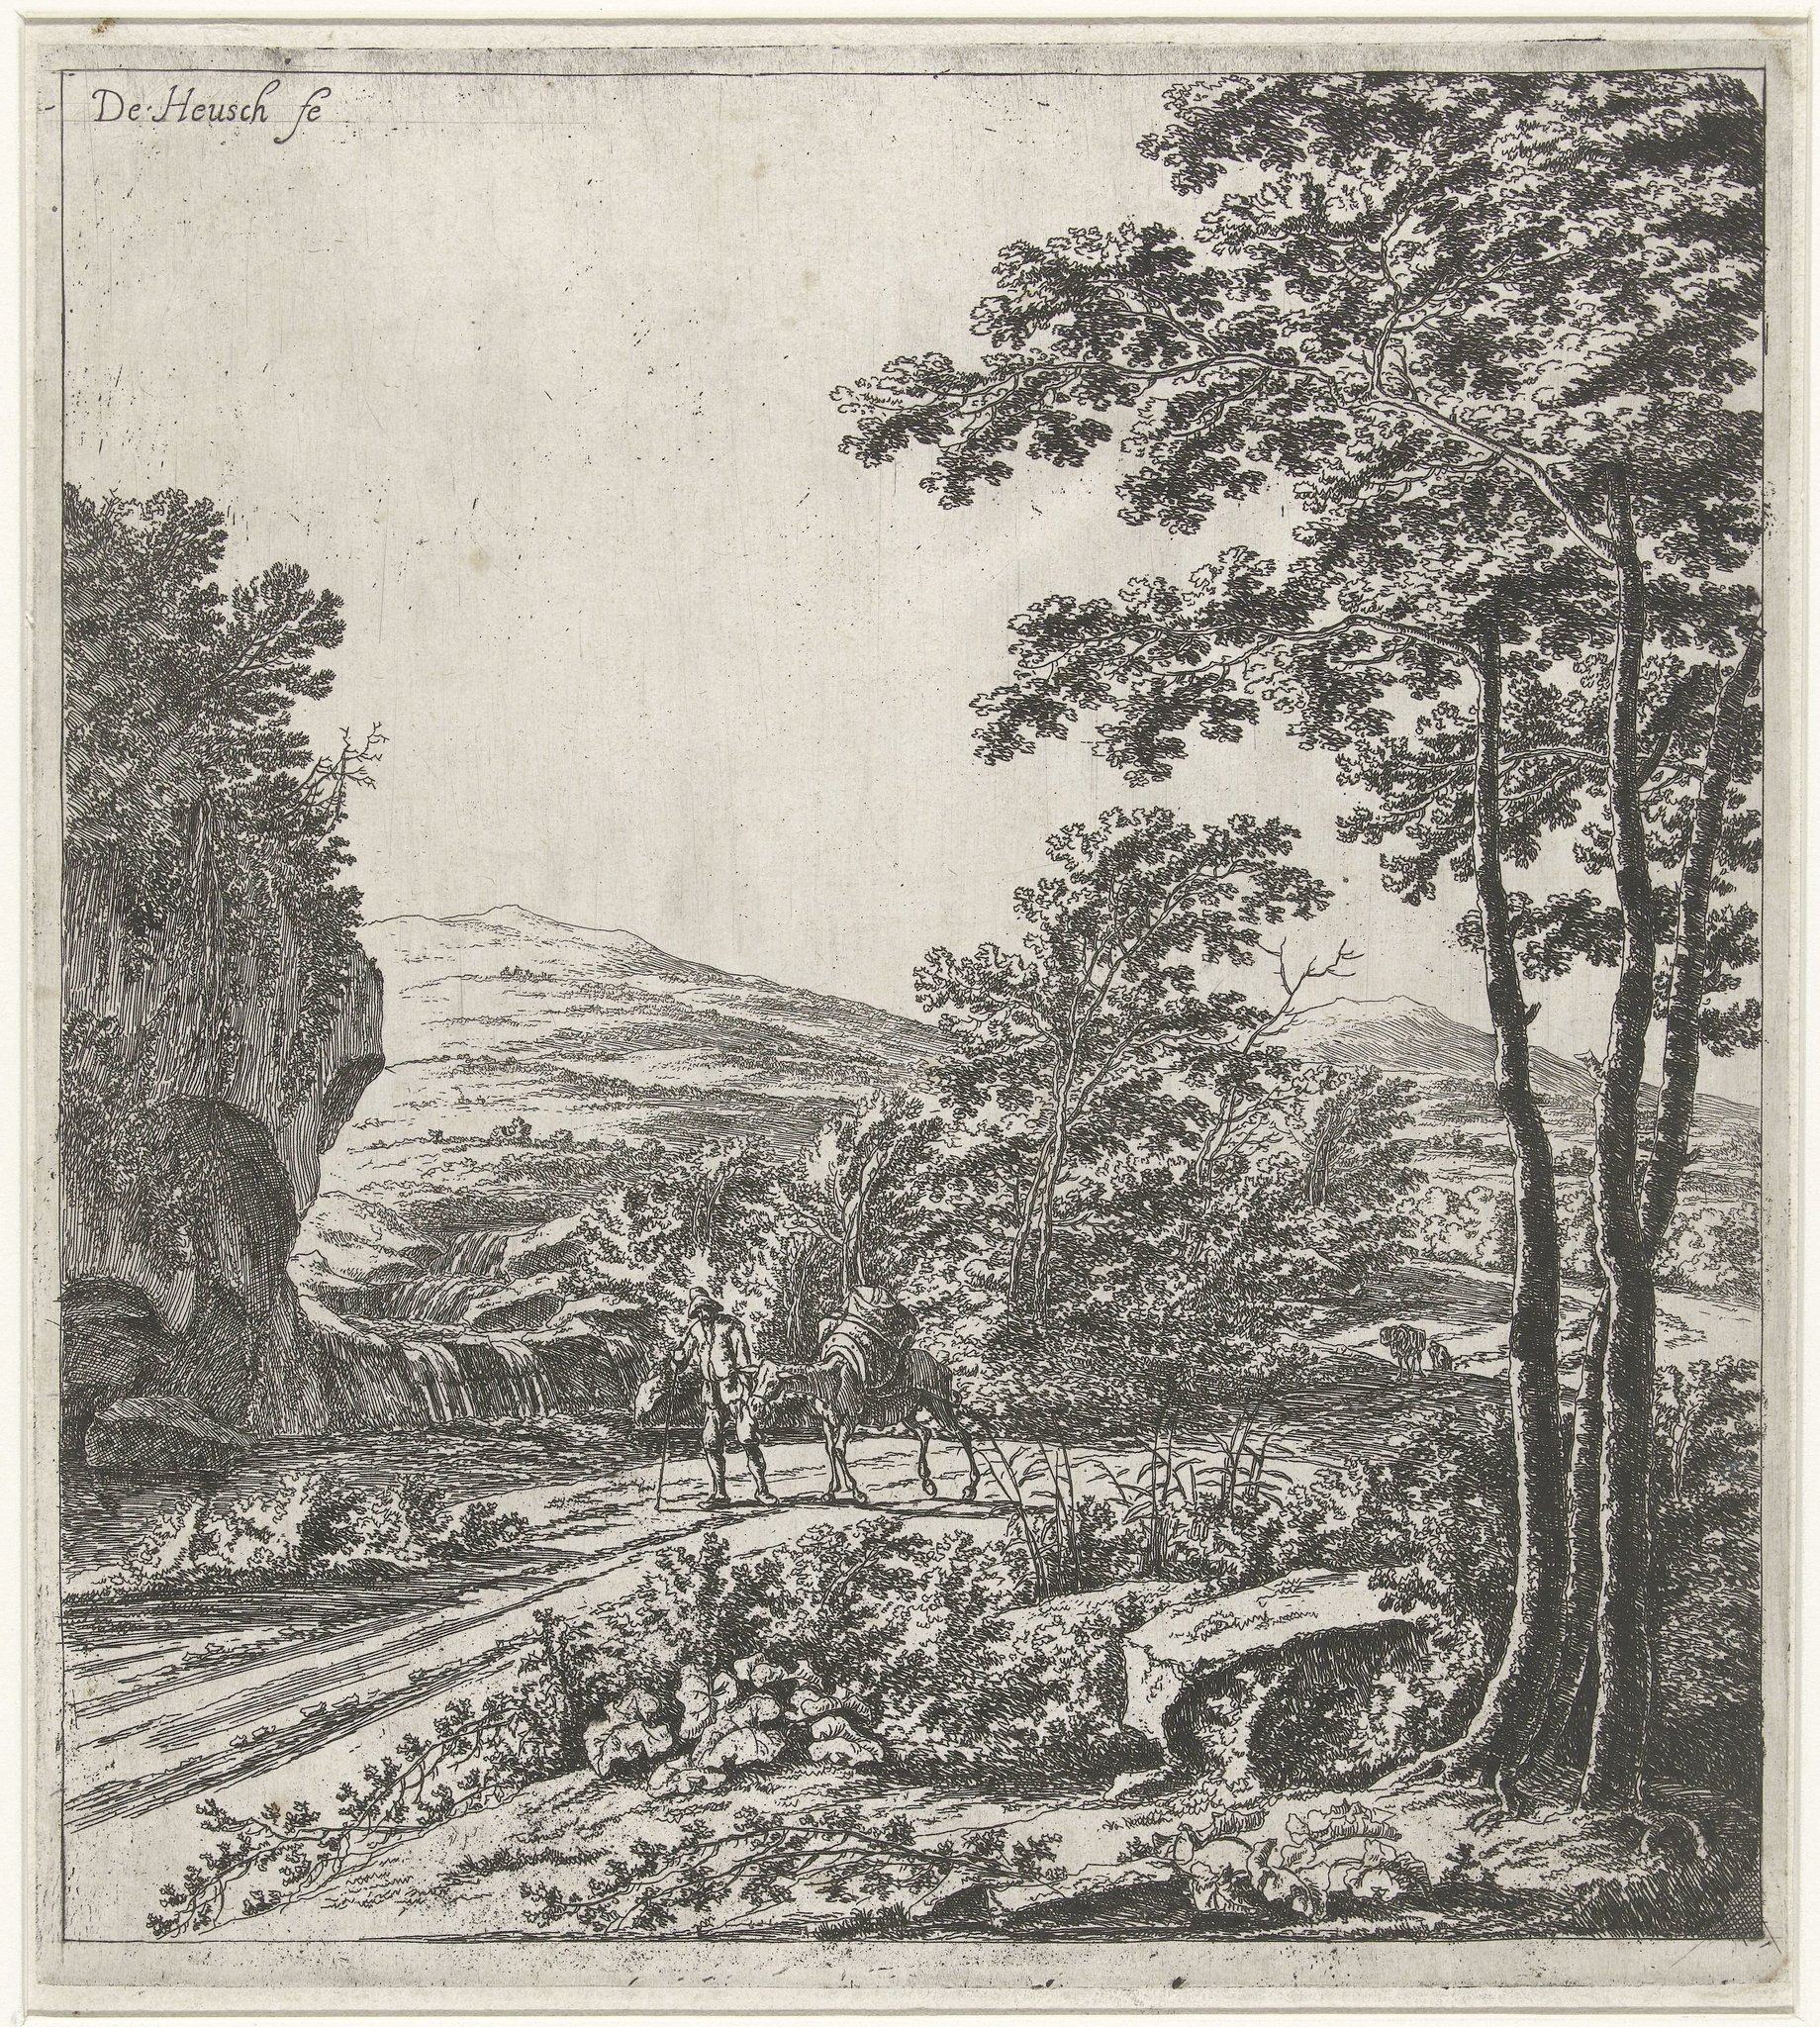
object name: print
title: Landschap met een muilezeldrijver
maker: willem de heusch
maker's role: draughtsman, painter, print maker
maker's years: 1625-1692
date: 1635-1692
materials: paper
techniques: etching, intaglio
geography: utrecht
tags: mule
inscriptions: collector's mark: Lugt 240